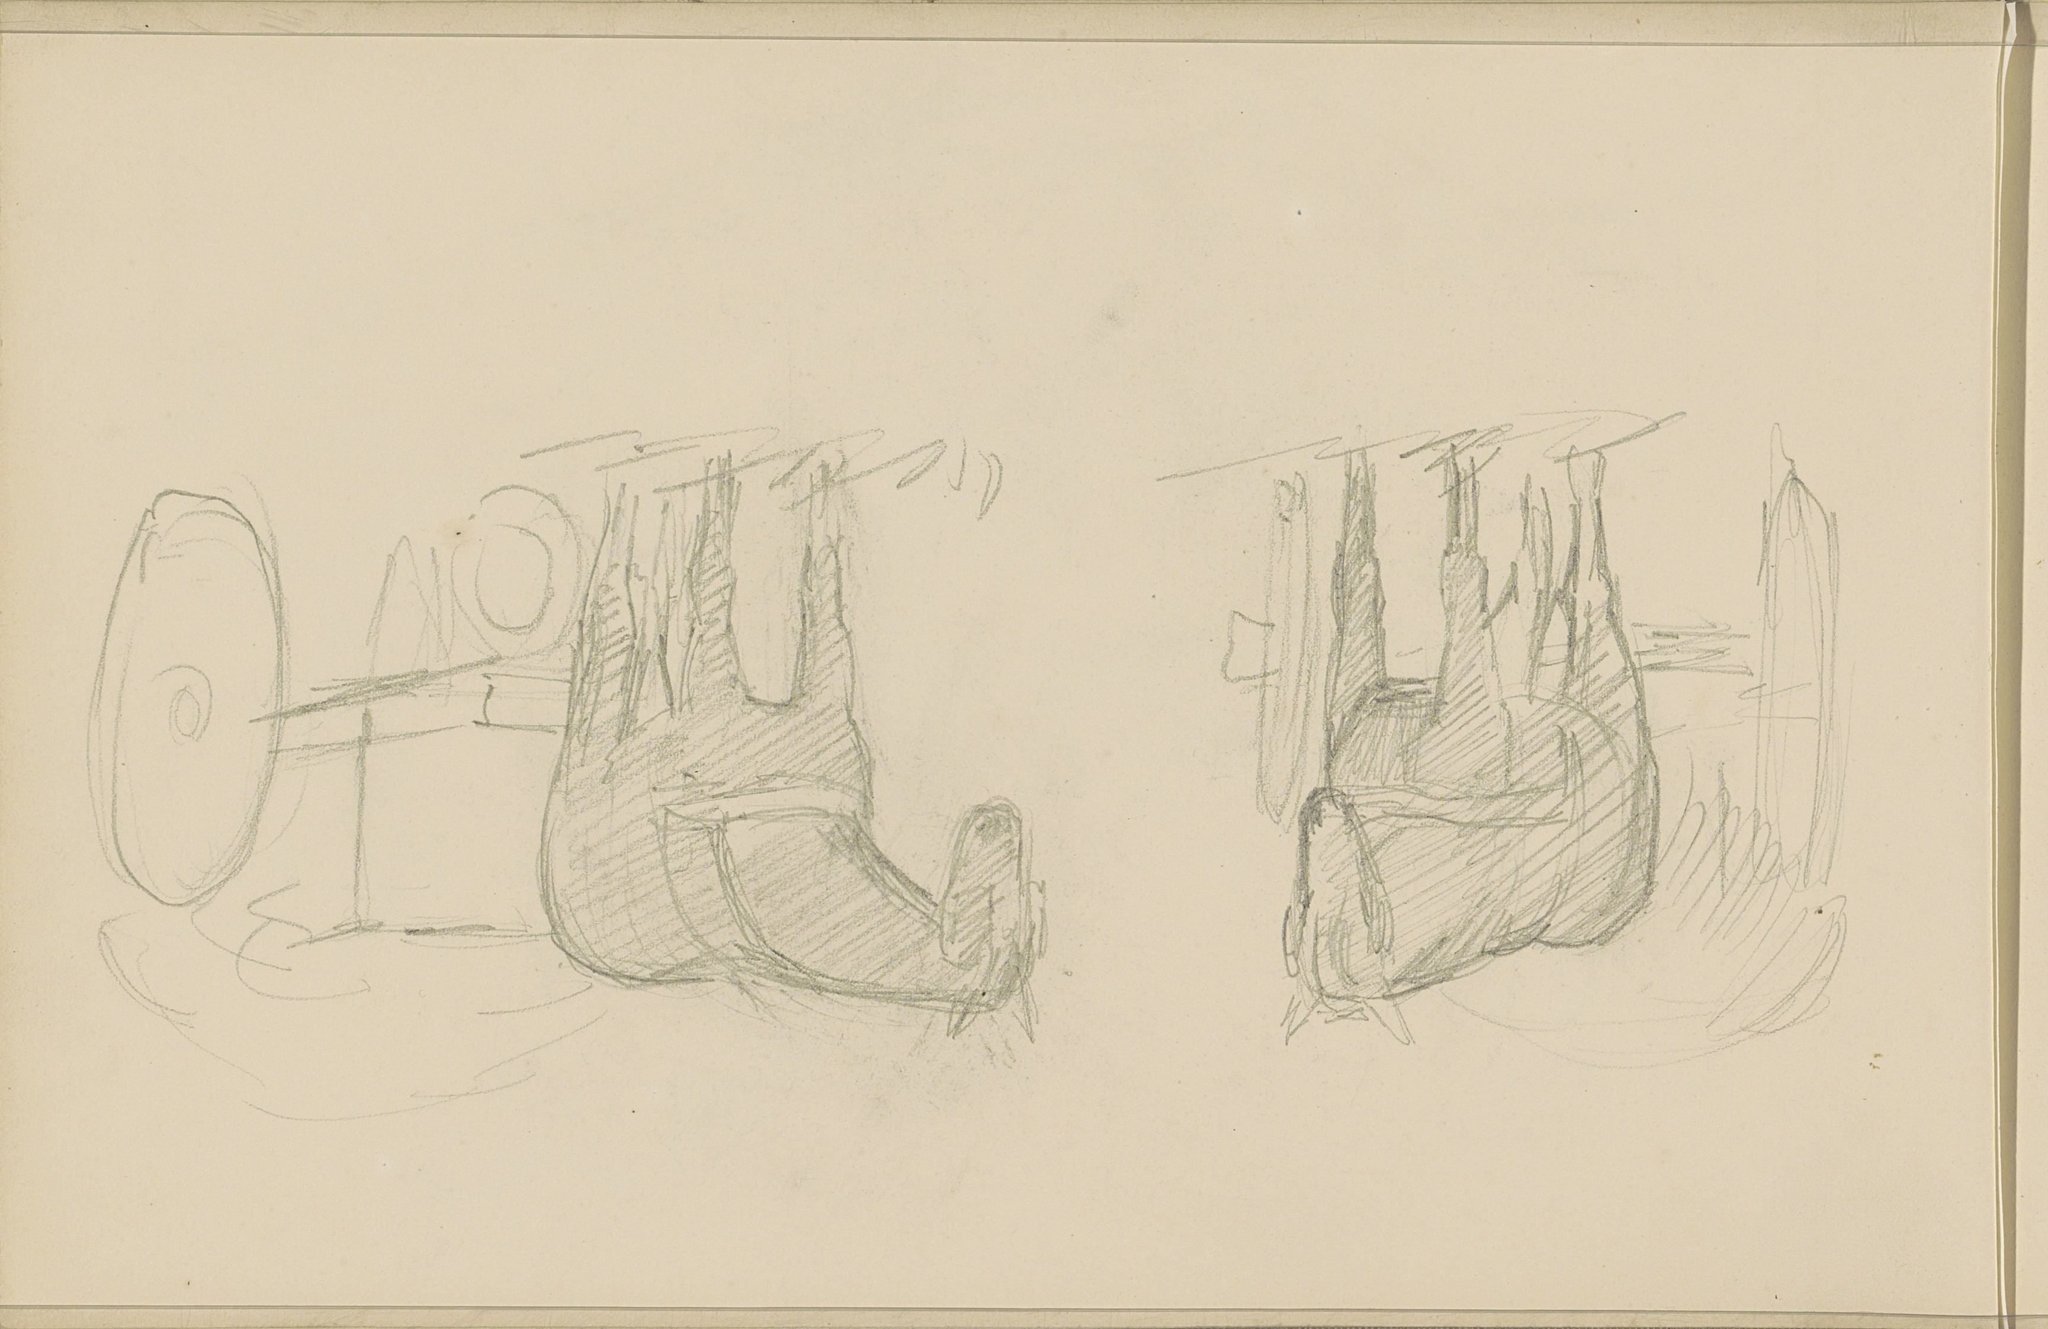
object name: sketchbook leaf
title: Paard voor een kar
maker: jozef israëls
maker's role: draughtsman, painter, print maker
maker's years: 1824-1911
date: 1834-1911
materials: paper, pencil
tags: horse, (farm) wagon, freight wagon, cart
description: Blad 10 verso uit een schetsboek met 25 bladen.